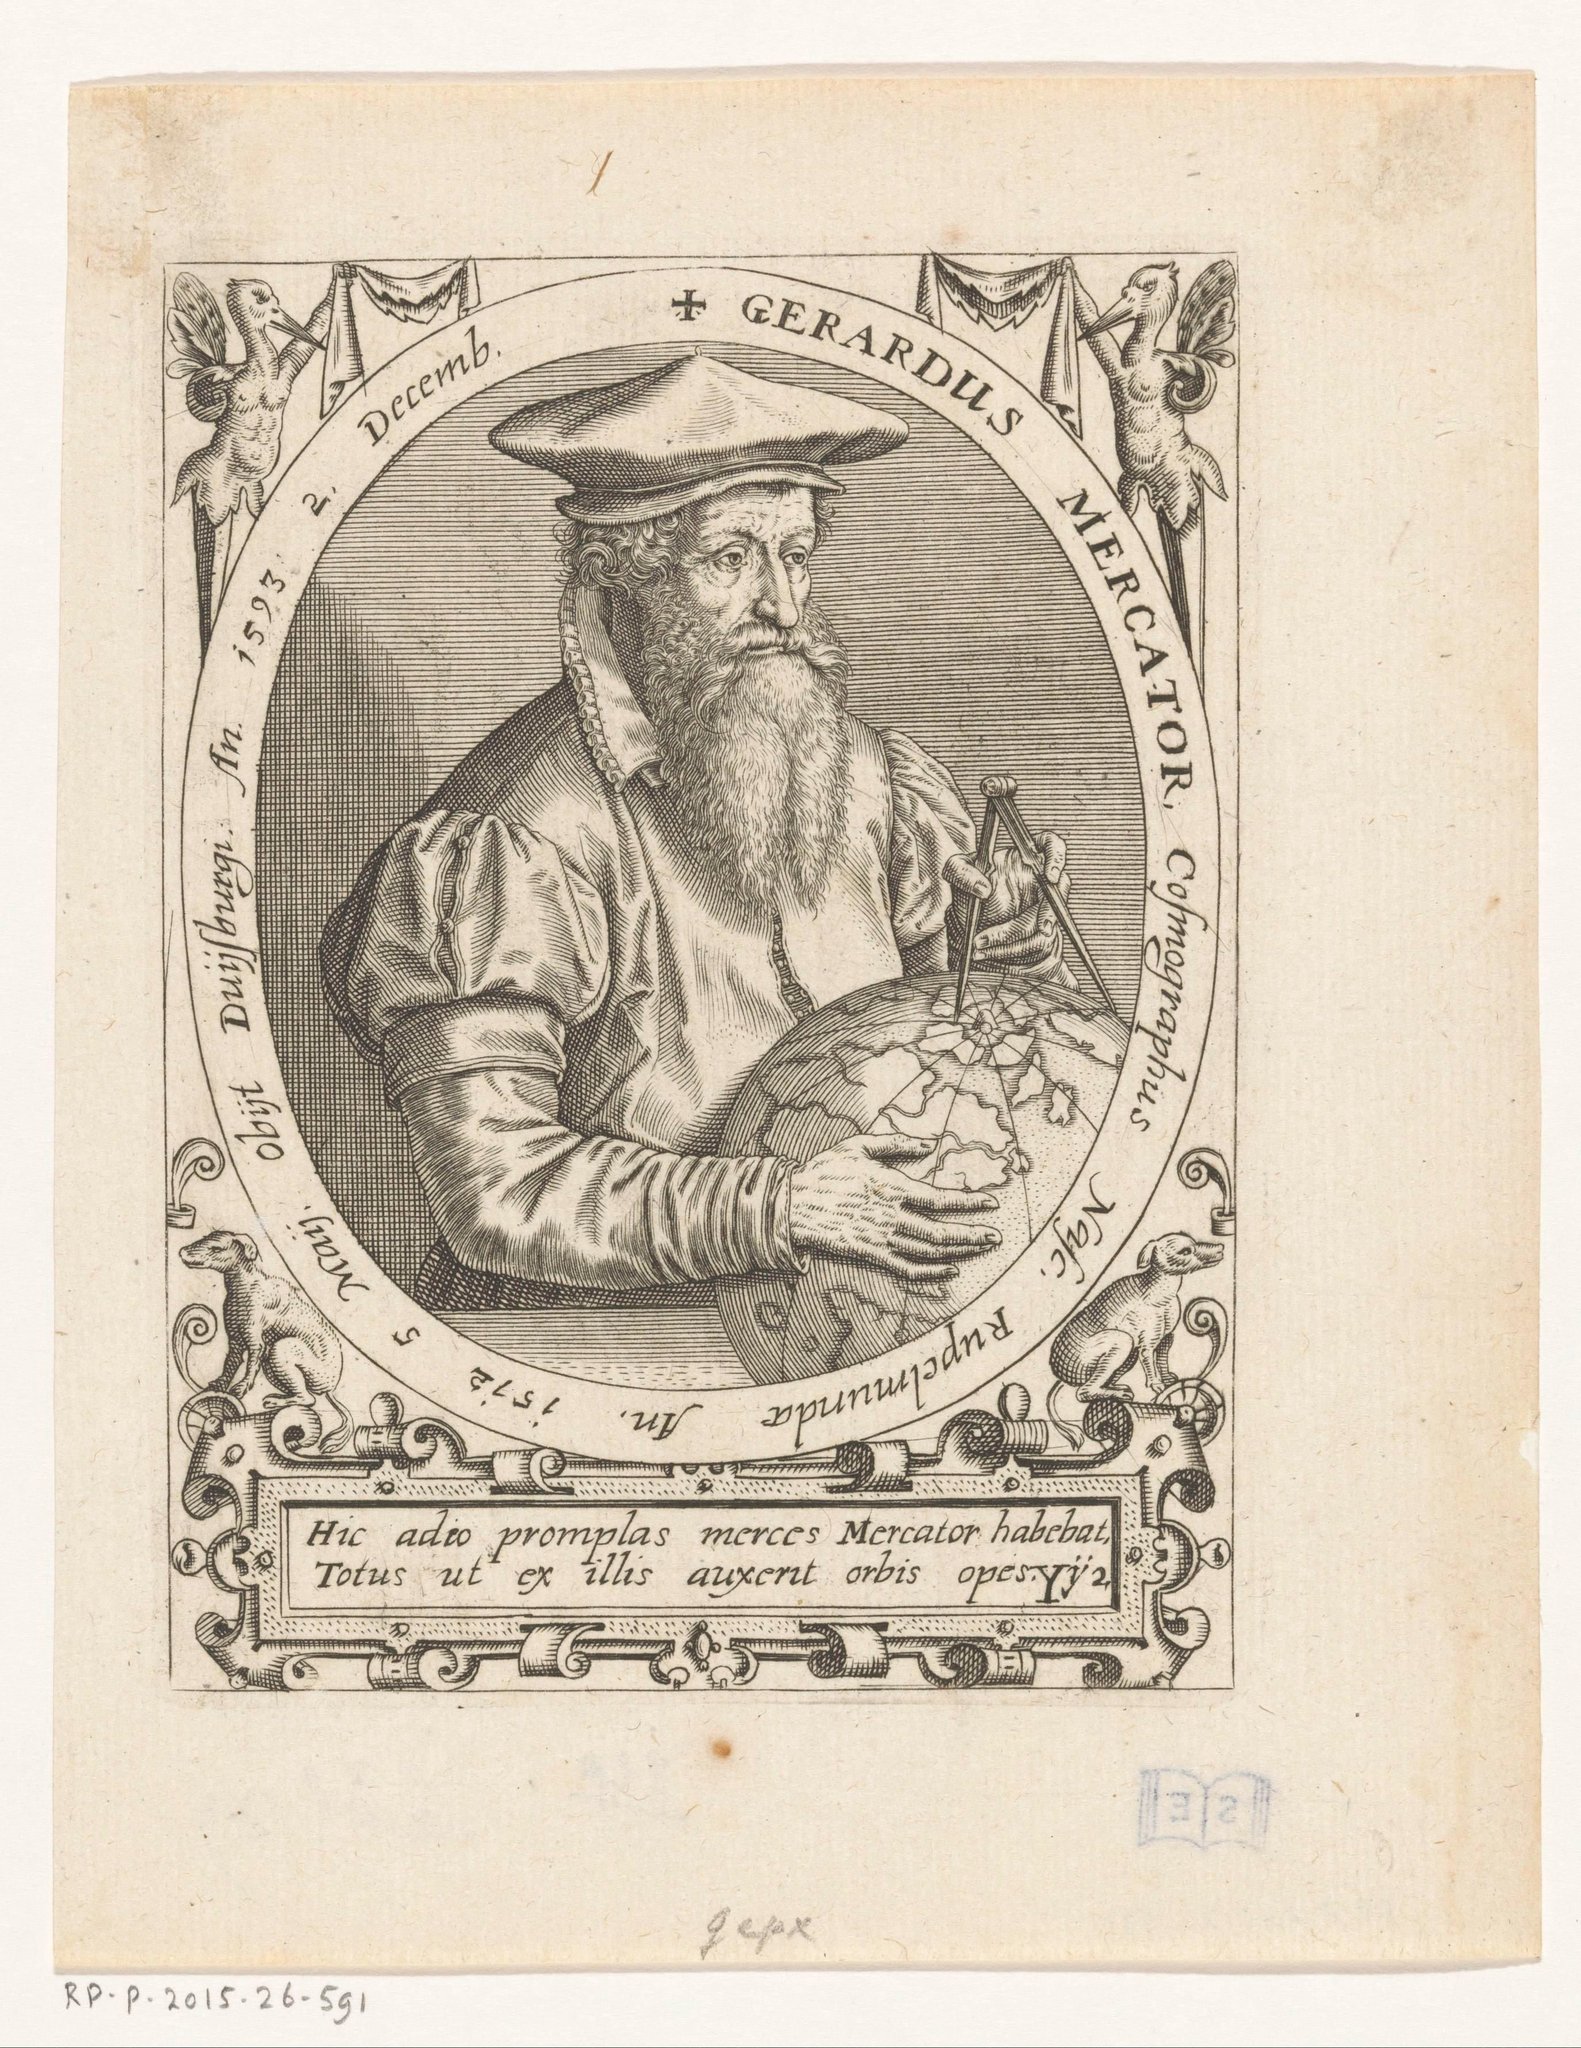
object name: print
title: Portret van Gerardus Mercator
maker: johann theodor de bry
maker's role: print maker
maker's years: 1561-1623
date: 1597-1625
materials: paper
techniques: engraving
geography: frankfurt am main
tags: instrument maker, gerardus mercator, ornament ~ hybrid animals, scrollwork, strapwork ~ ornament, globe, compass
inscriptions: collector's mark: Lugt 2228, collector's mark: Lugt 4779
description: Prent afkomstig uit: Bibliotheca chalcographica, hoc est Virtute et eruditione clarorum Virorum Imagines. Frankfurt am Main. Deze uitgave vormde de voortzetting van de serie Icones virorum illustrium doctrina et eruditione praestantium, uitgegeven door Theodor de Bry, 1597-1598.